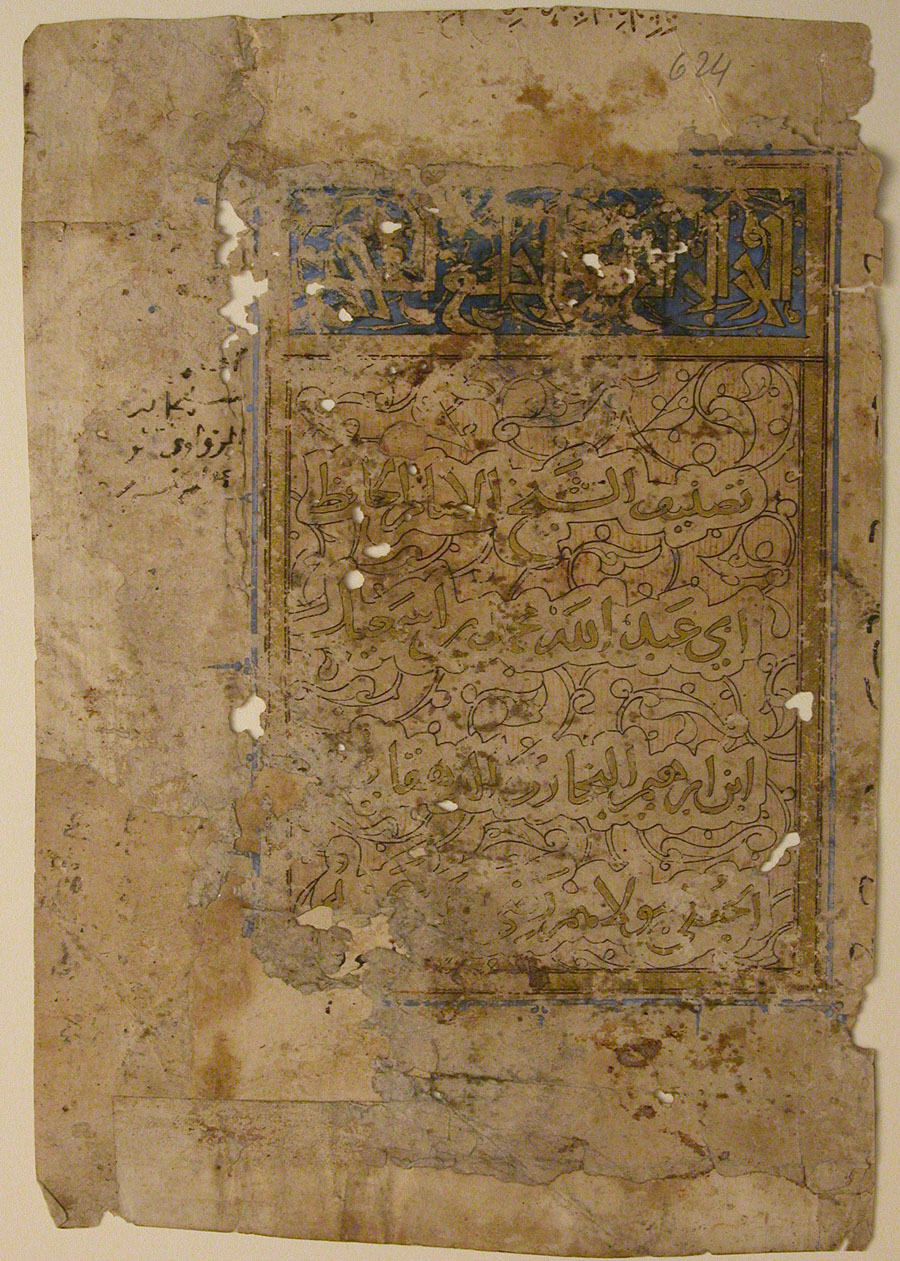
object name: folio from a non illustrated manuscript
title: Page of Calligraphy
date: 1401-1500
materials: gold, ink, paper, watercolor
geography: egypt or iran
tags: calligraphy